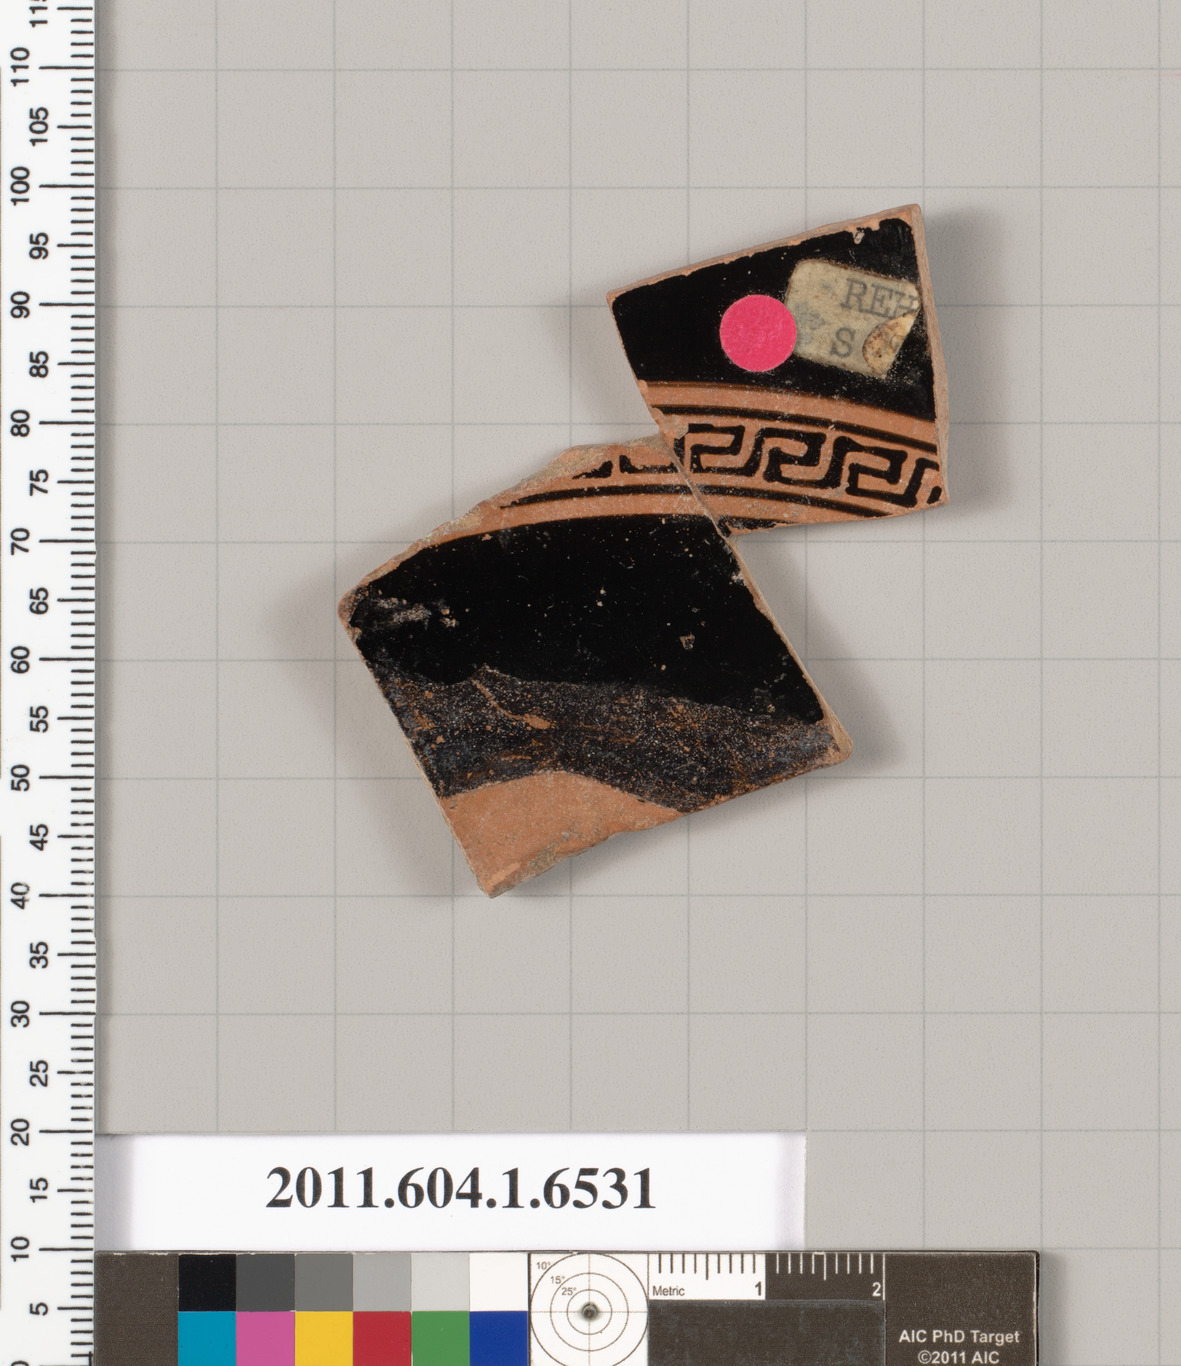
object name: kylix fragment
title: Terracotta fragment of a kylix (drinking cup)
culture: greek, attic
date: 490-480 BCE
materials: terracotta